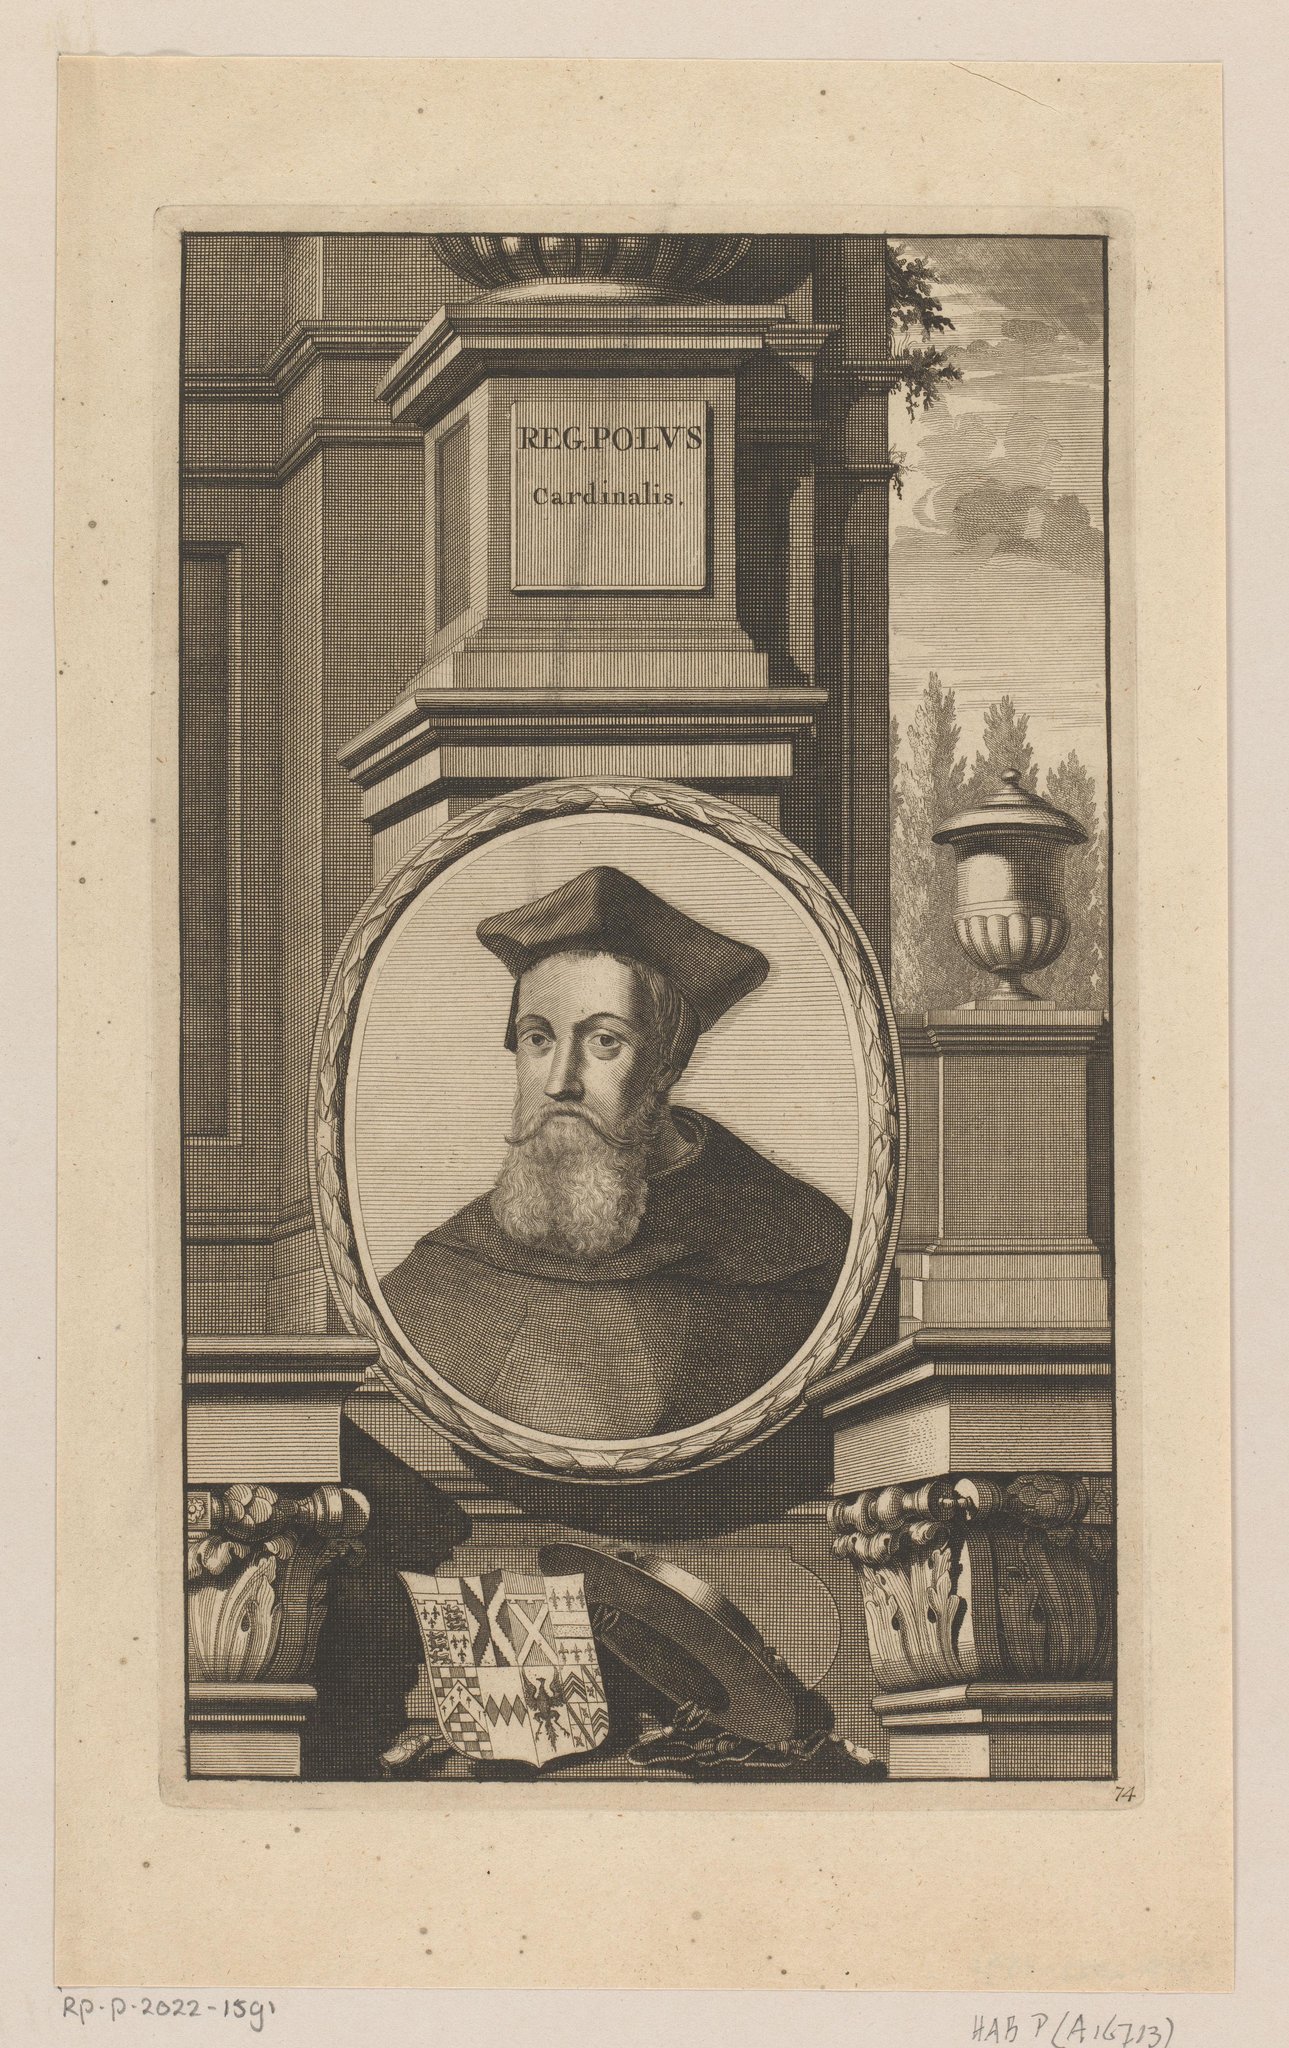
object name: print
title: Portretten van belangrijke leiders en geleerden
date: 1710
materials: paper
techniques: engraving, etching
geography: northern netherlands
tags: london, cardinal, historical persons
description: Prent uit de serie: Principum et illustrium quorundam virorum qui in Europa alibique terrarum quam fama quam eruditione celebres fuerunt, verae imagines. Leiden: Pieter van der Aa, [ca. 1710].